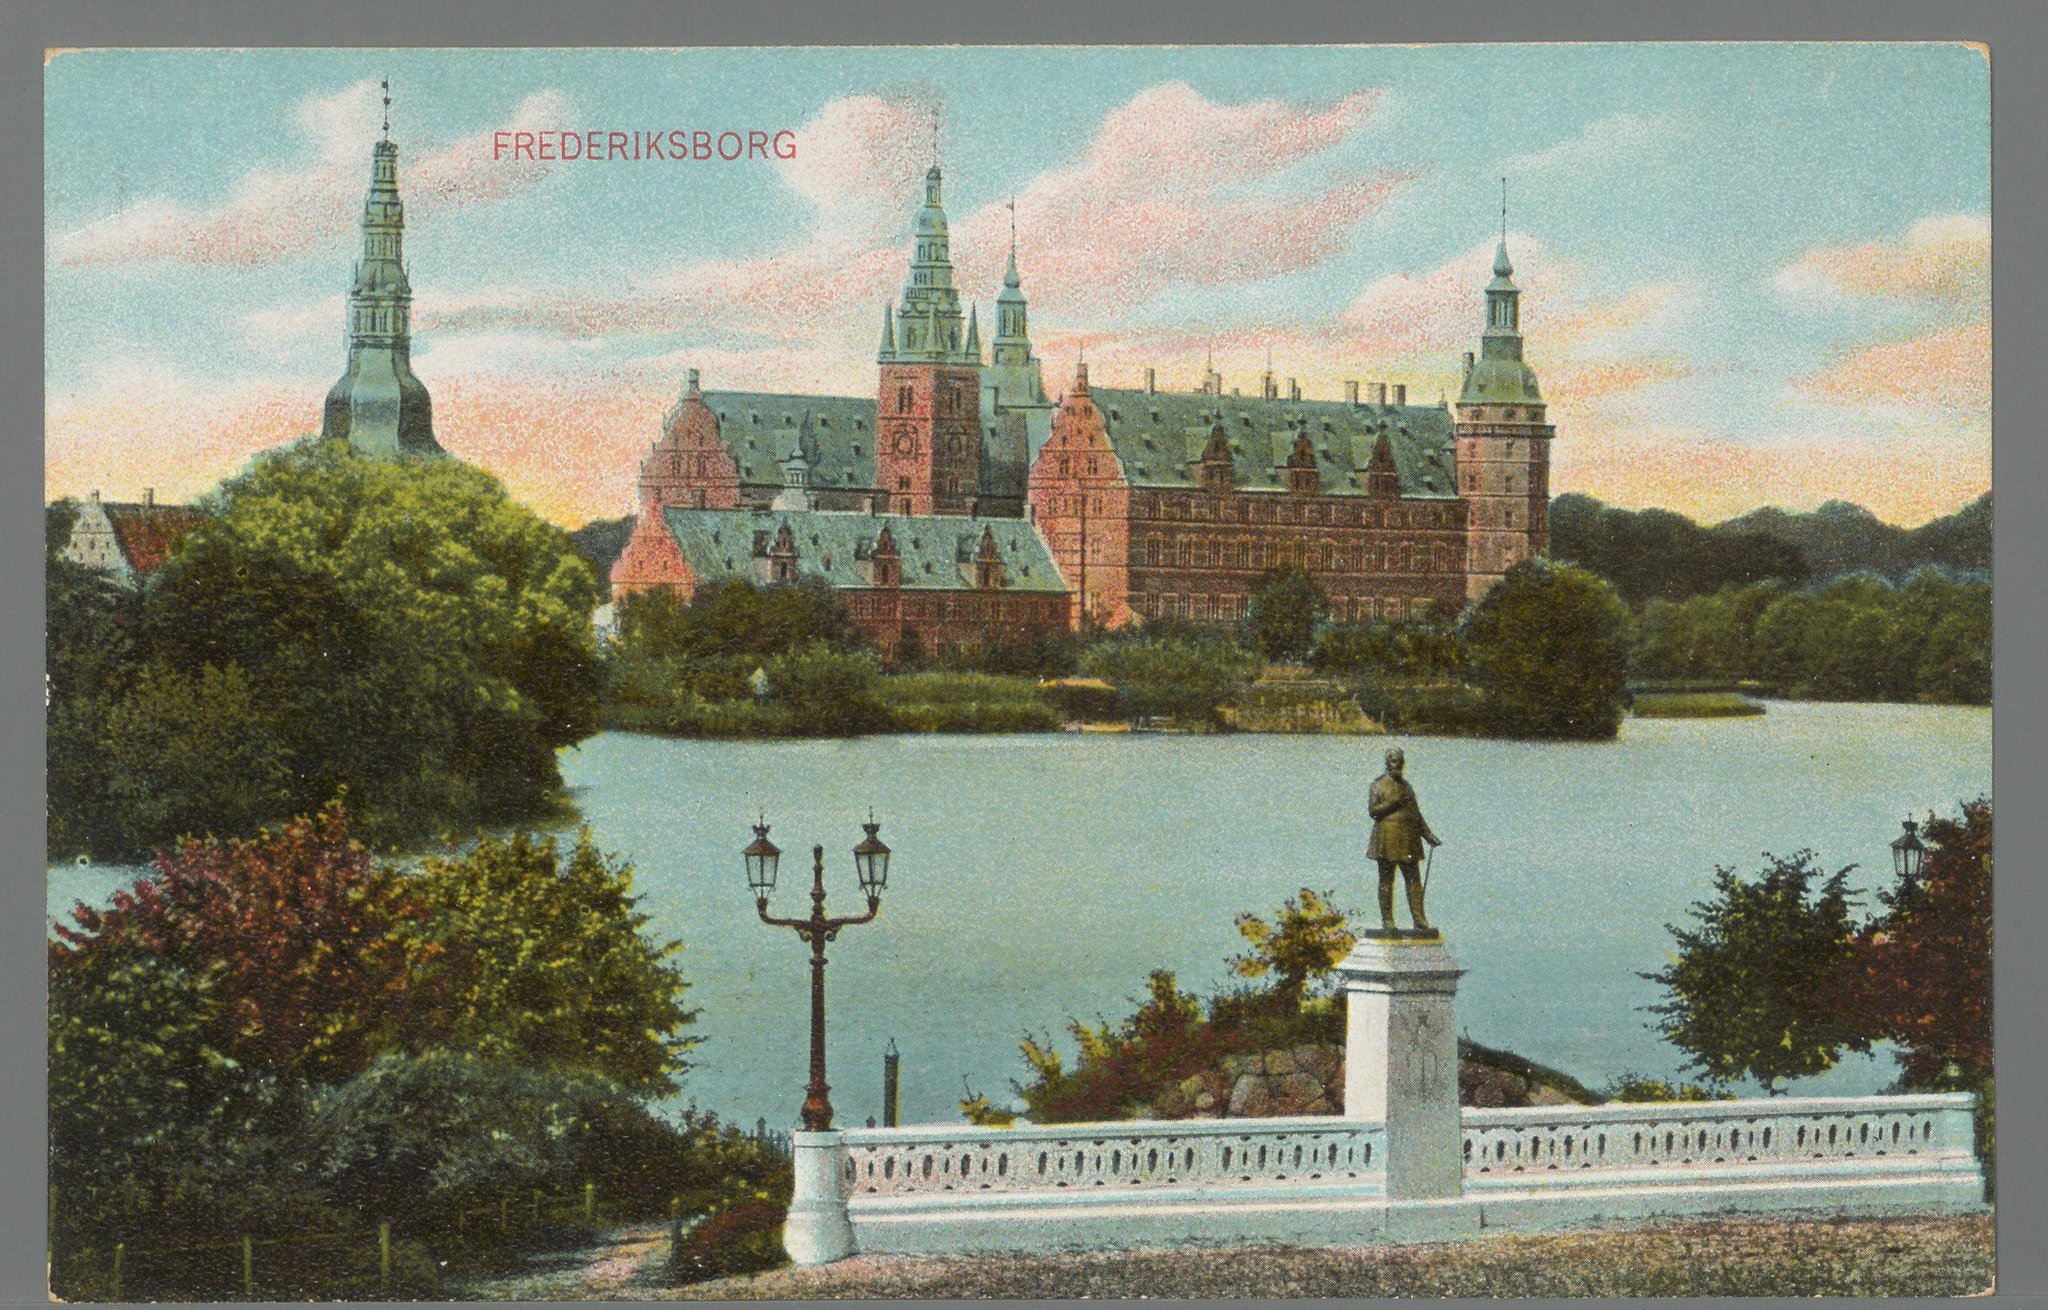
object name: photomechanical print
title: Frederiksborg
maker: Anonymous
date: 1906-1920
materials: cardboard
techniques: lithograph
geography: hillerød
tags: park, palace, pond, pool